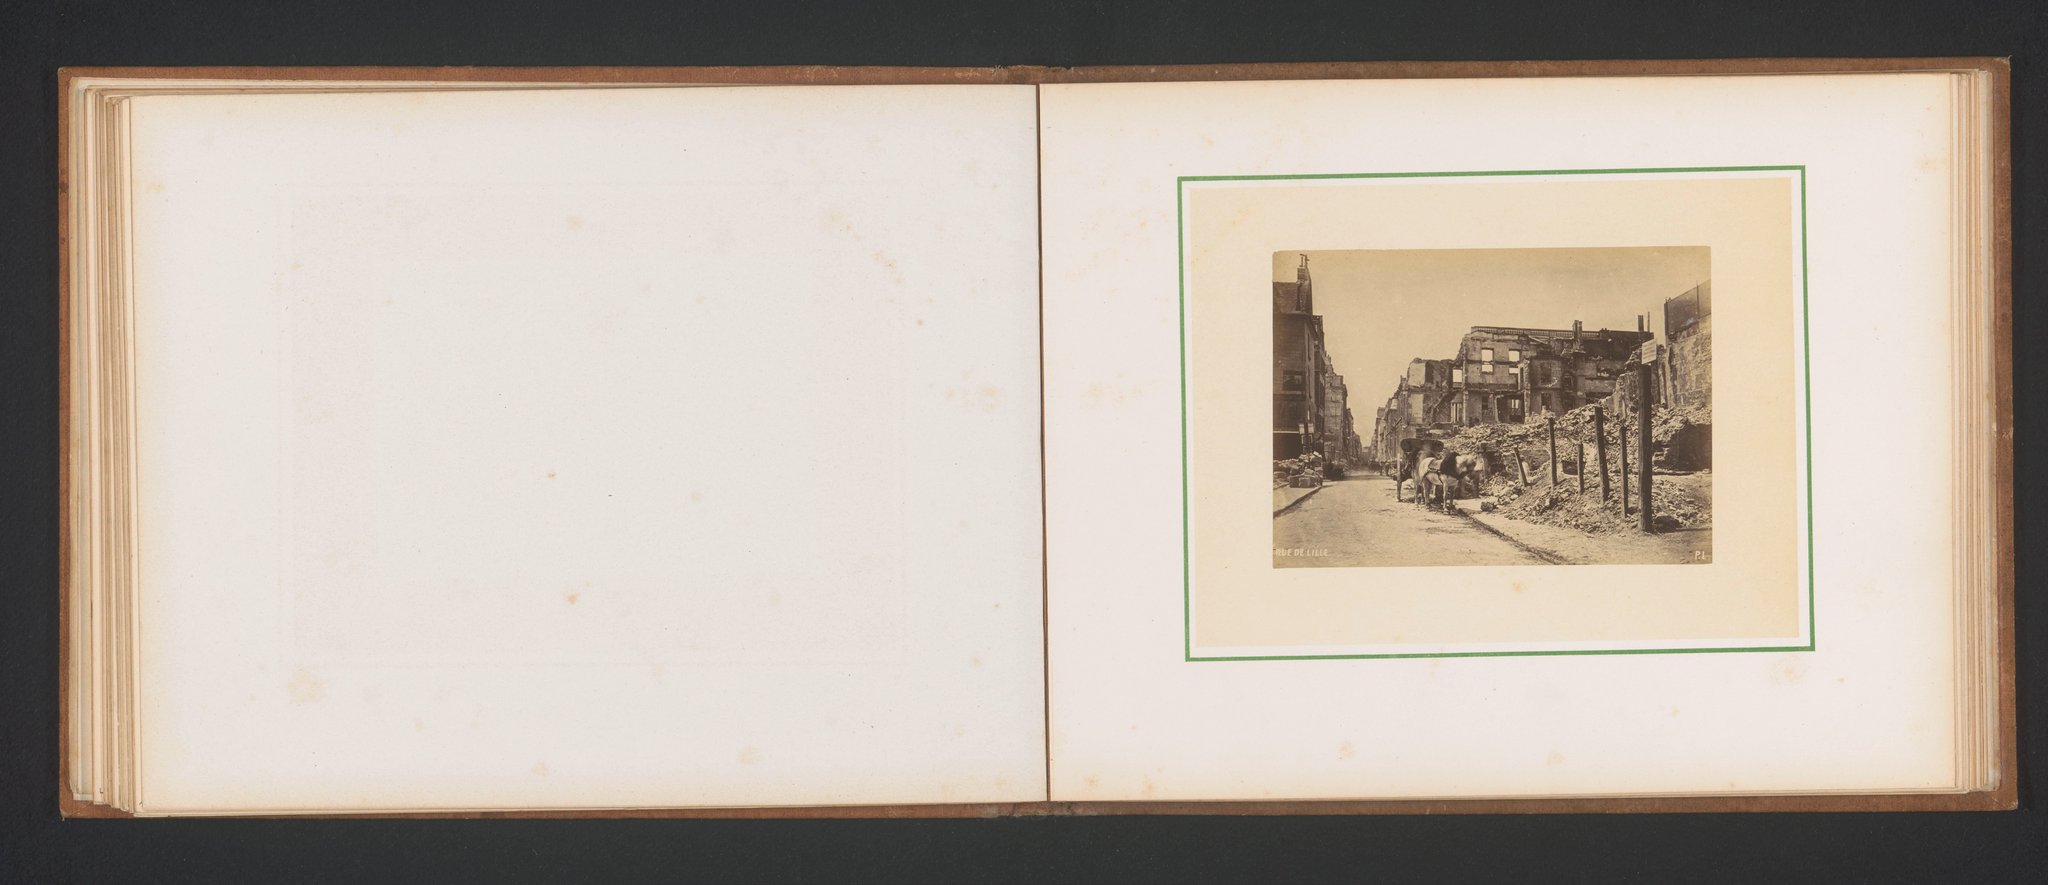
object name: photograph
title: Gezicht op de Rue de Lille na de brand door de Commune van Parijs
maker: p. loubère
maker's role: fotograaf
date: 1871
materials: photographic support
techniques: albumen print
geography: paris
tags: ruin of a building ~ architecture, street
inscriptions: monogram: ‘P.L.’